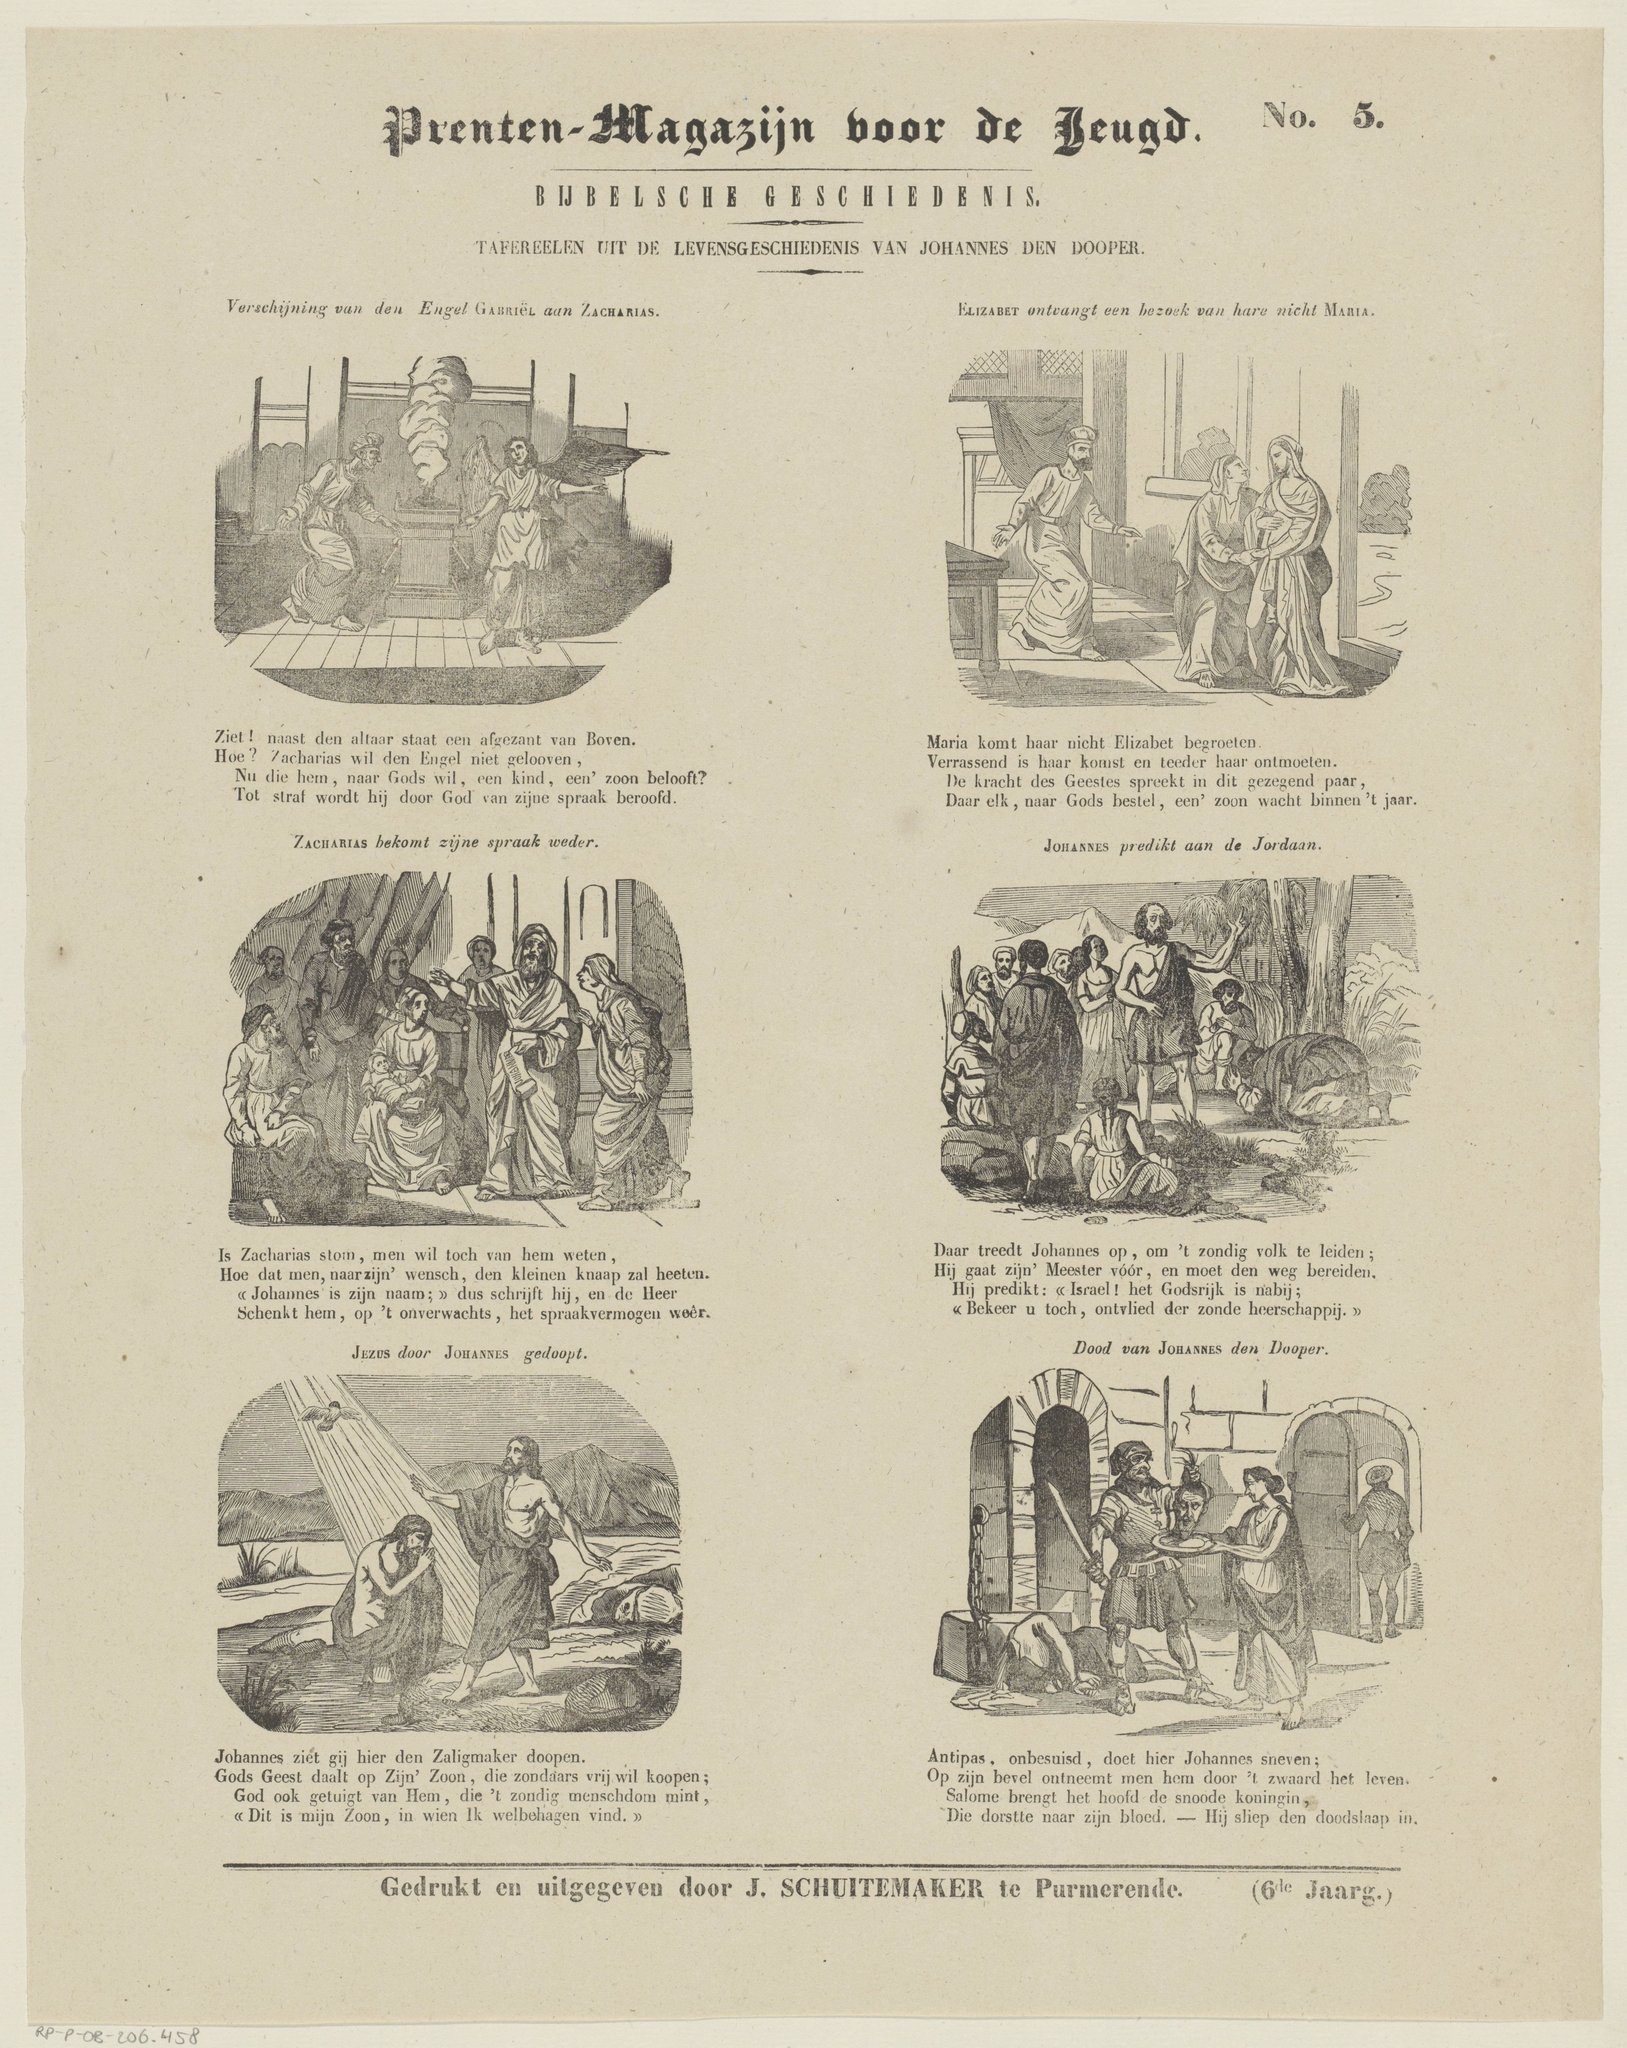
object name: print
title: Prenten-magazijn voor de jeugd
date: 1847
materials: paper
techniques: letterpress printing, engraving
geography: netherlands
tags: john the baptist baptizing, visitation (possibly joseph and/or zacharias present) (luke 1:39-56), new testament, series of scenes from the life of john the baptist, john the baptist preaching (perhaps christ among the bystanders)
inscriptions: collector's mark: Lugt 2760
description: Blad met 6 voorstellingen uit het leven van Johannes de Doper. Boven elke voorstelling een titel en onder elke voorstelling een vierregelig vers. Genummerd rechtsboven: No. 5.